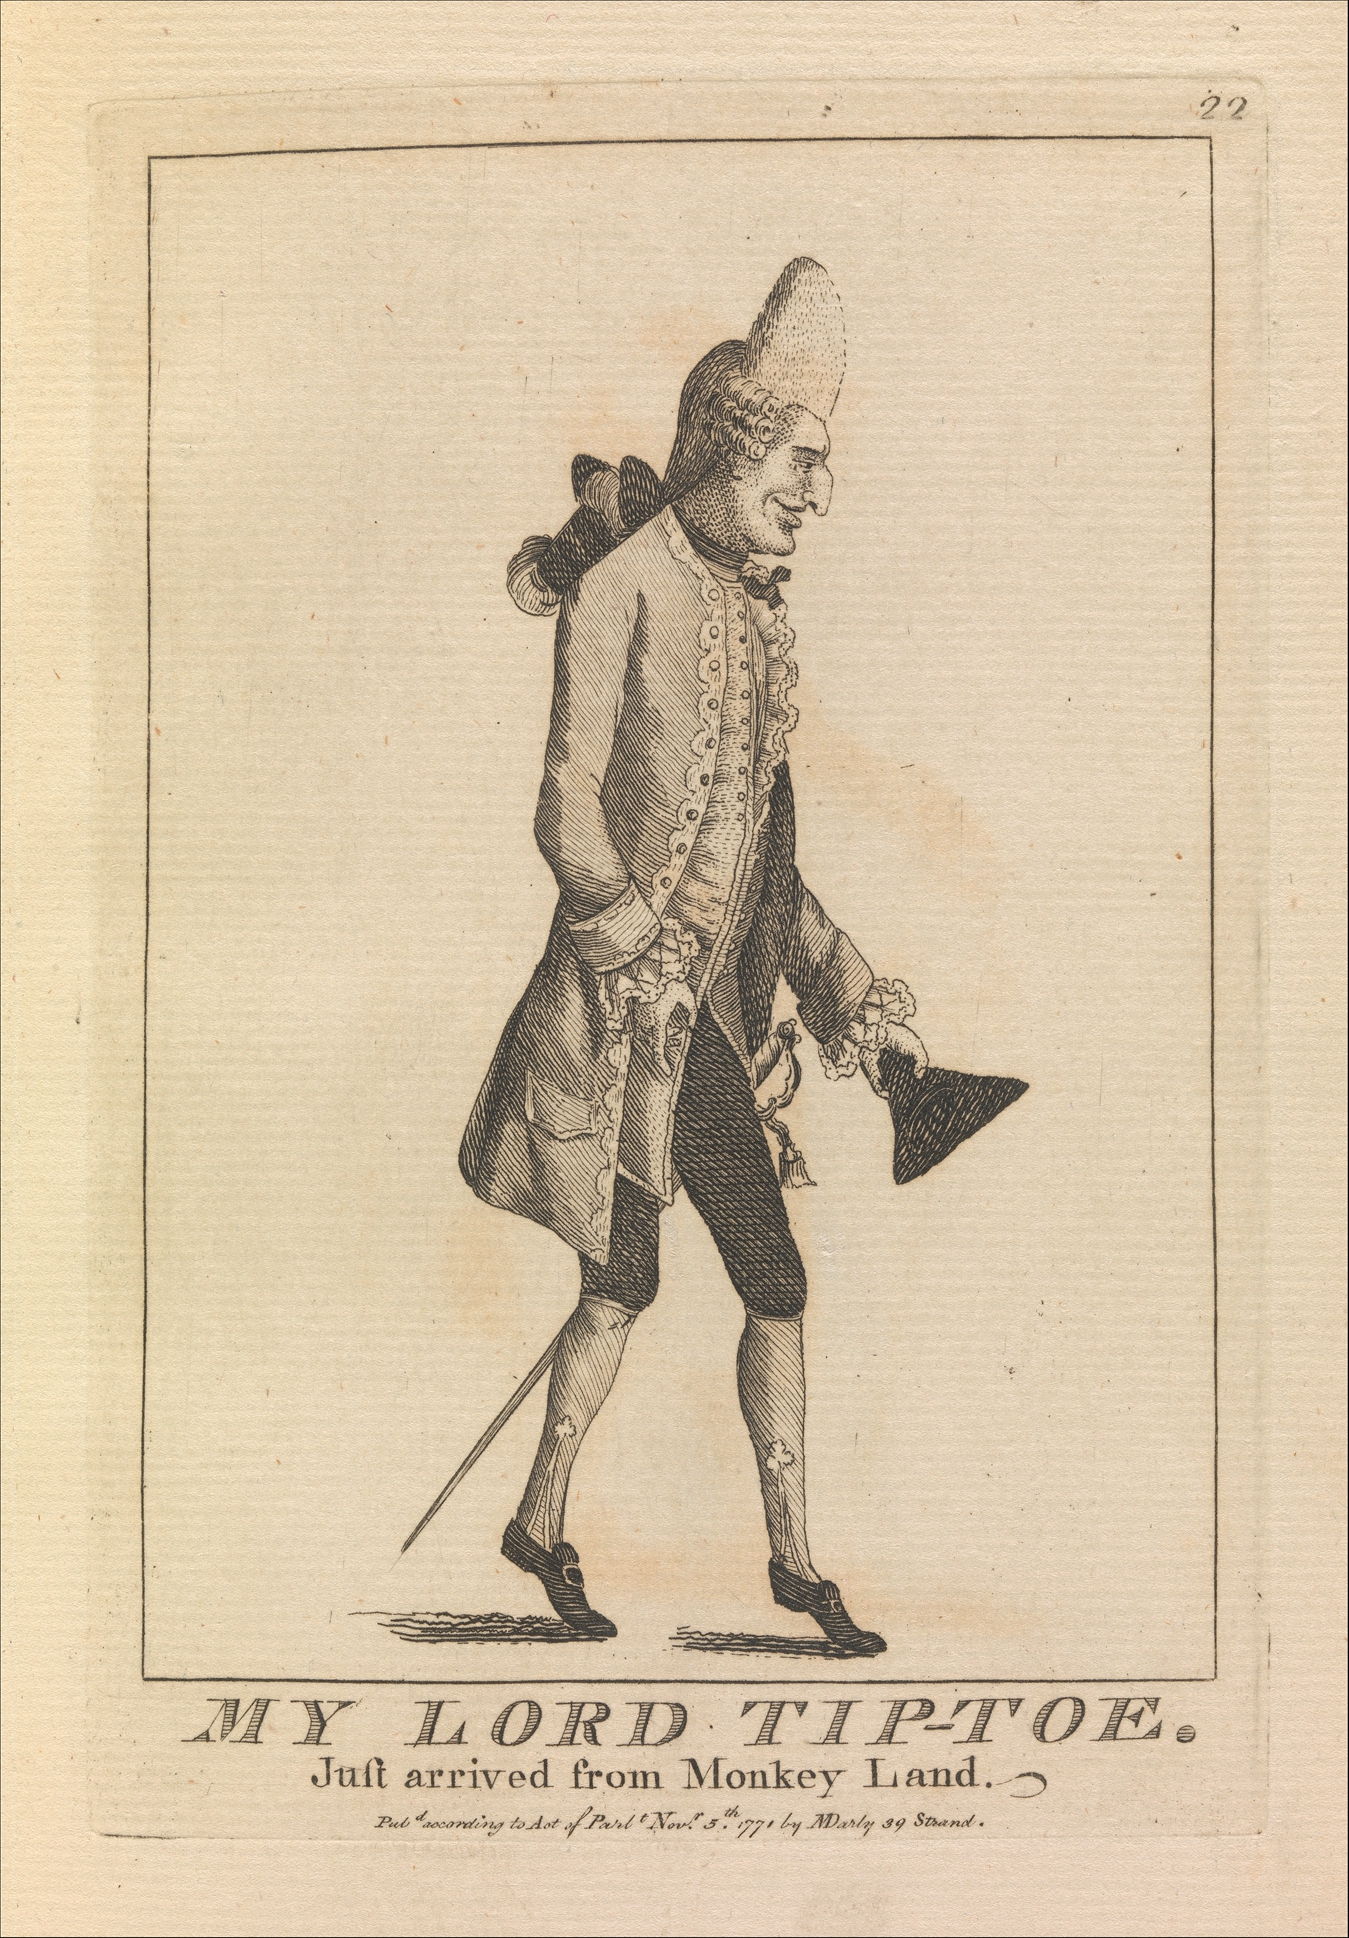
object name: print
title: My Lord Tip-Toe Just Arrived from Monkey Land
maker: matthias darly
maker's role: publisher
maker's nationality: british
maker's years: 1720-1780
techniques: etching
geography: london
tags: men,caricature